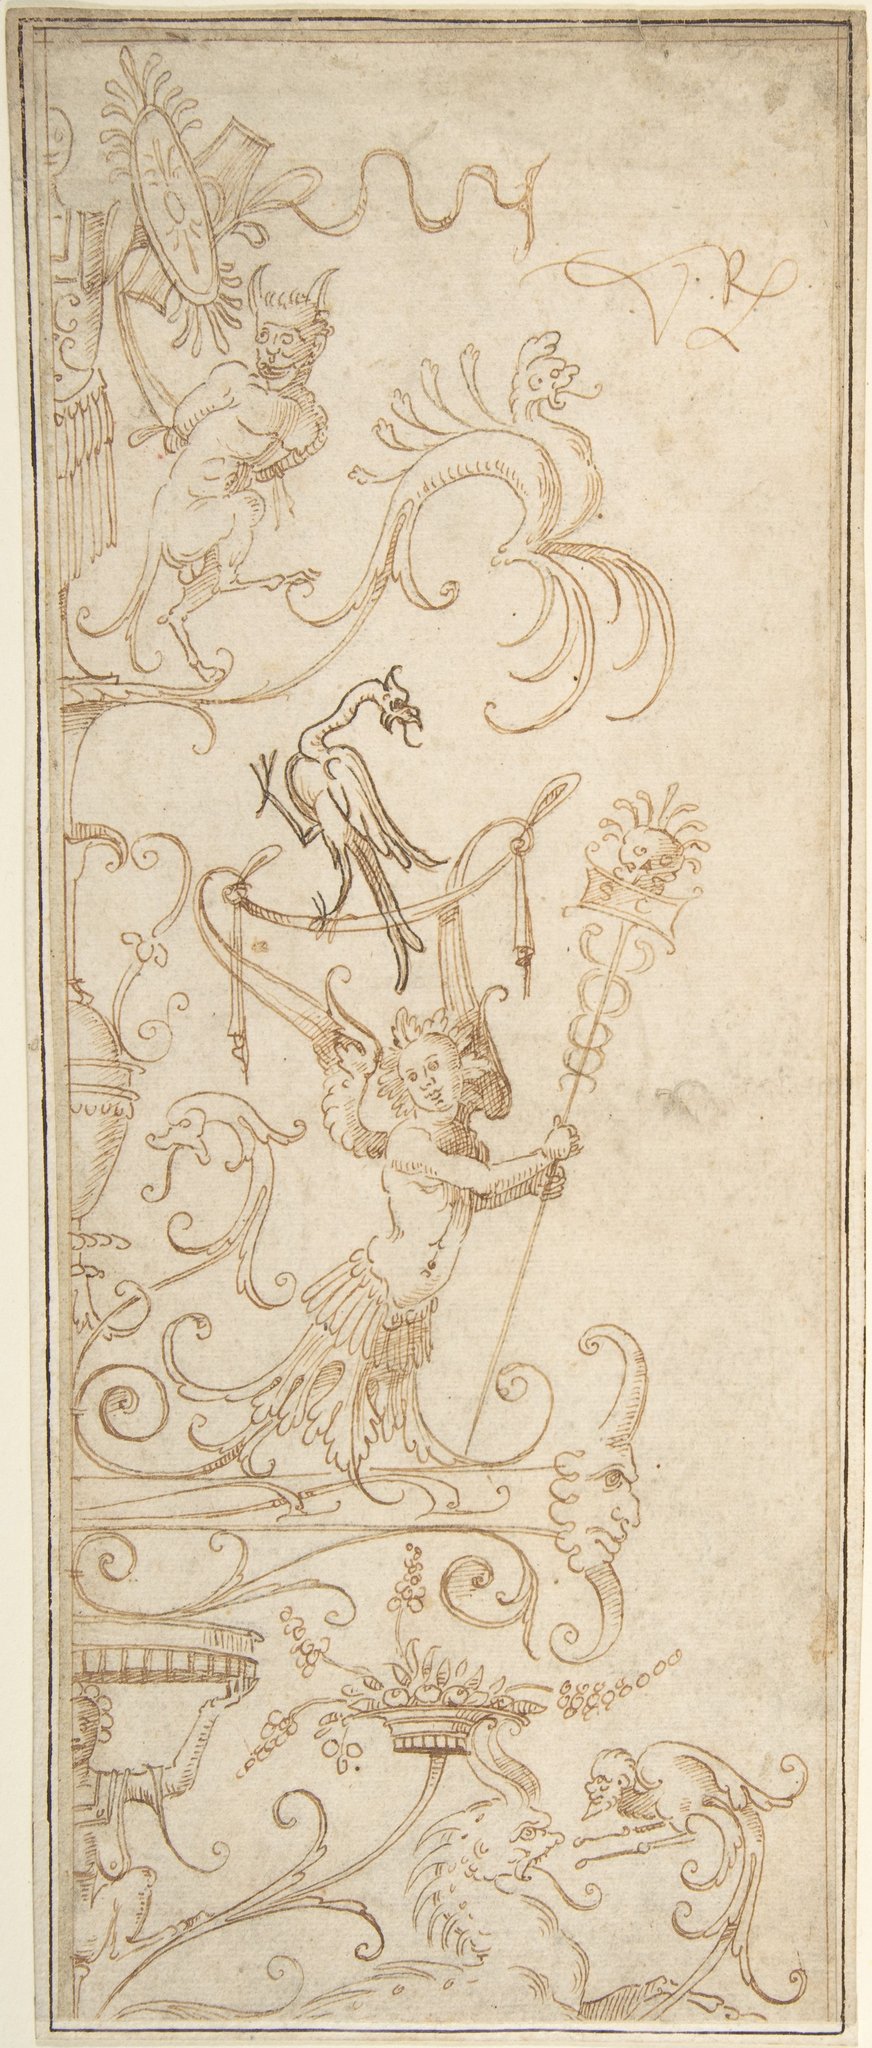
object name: drawing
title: Antique-Style Ornamental Oblong Design: Grotesque Figures, Masks, and Amphorae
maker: anonymous, italian, 16th century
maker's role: artist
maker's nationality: italian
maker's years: 1550-1600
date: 1501-1533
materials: ink, drawing material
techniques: pen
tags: birds,grotesques,ornament,mythical creatures